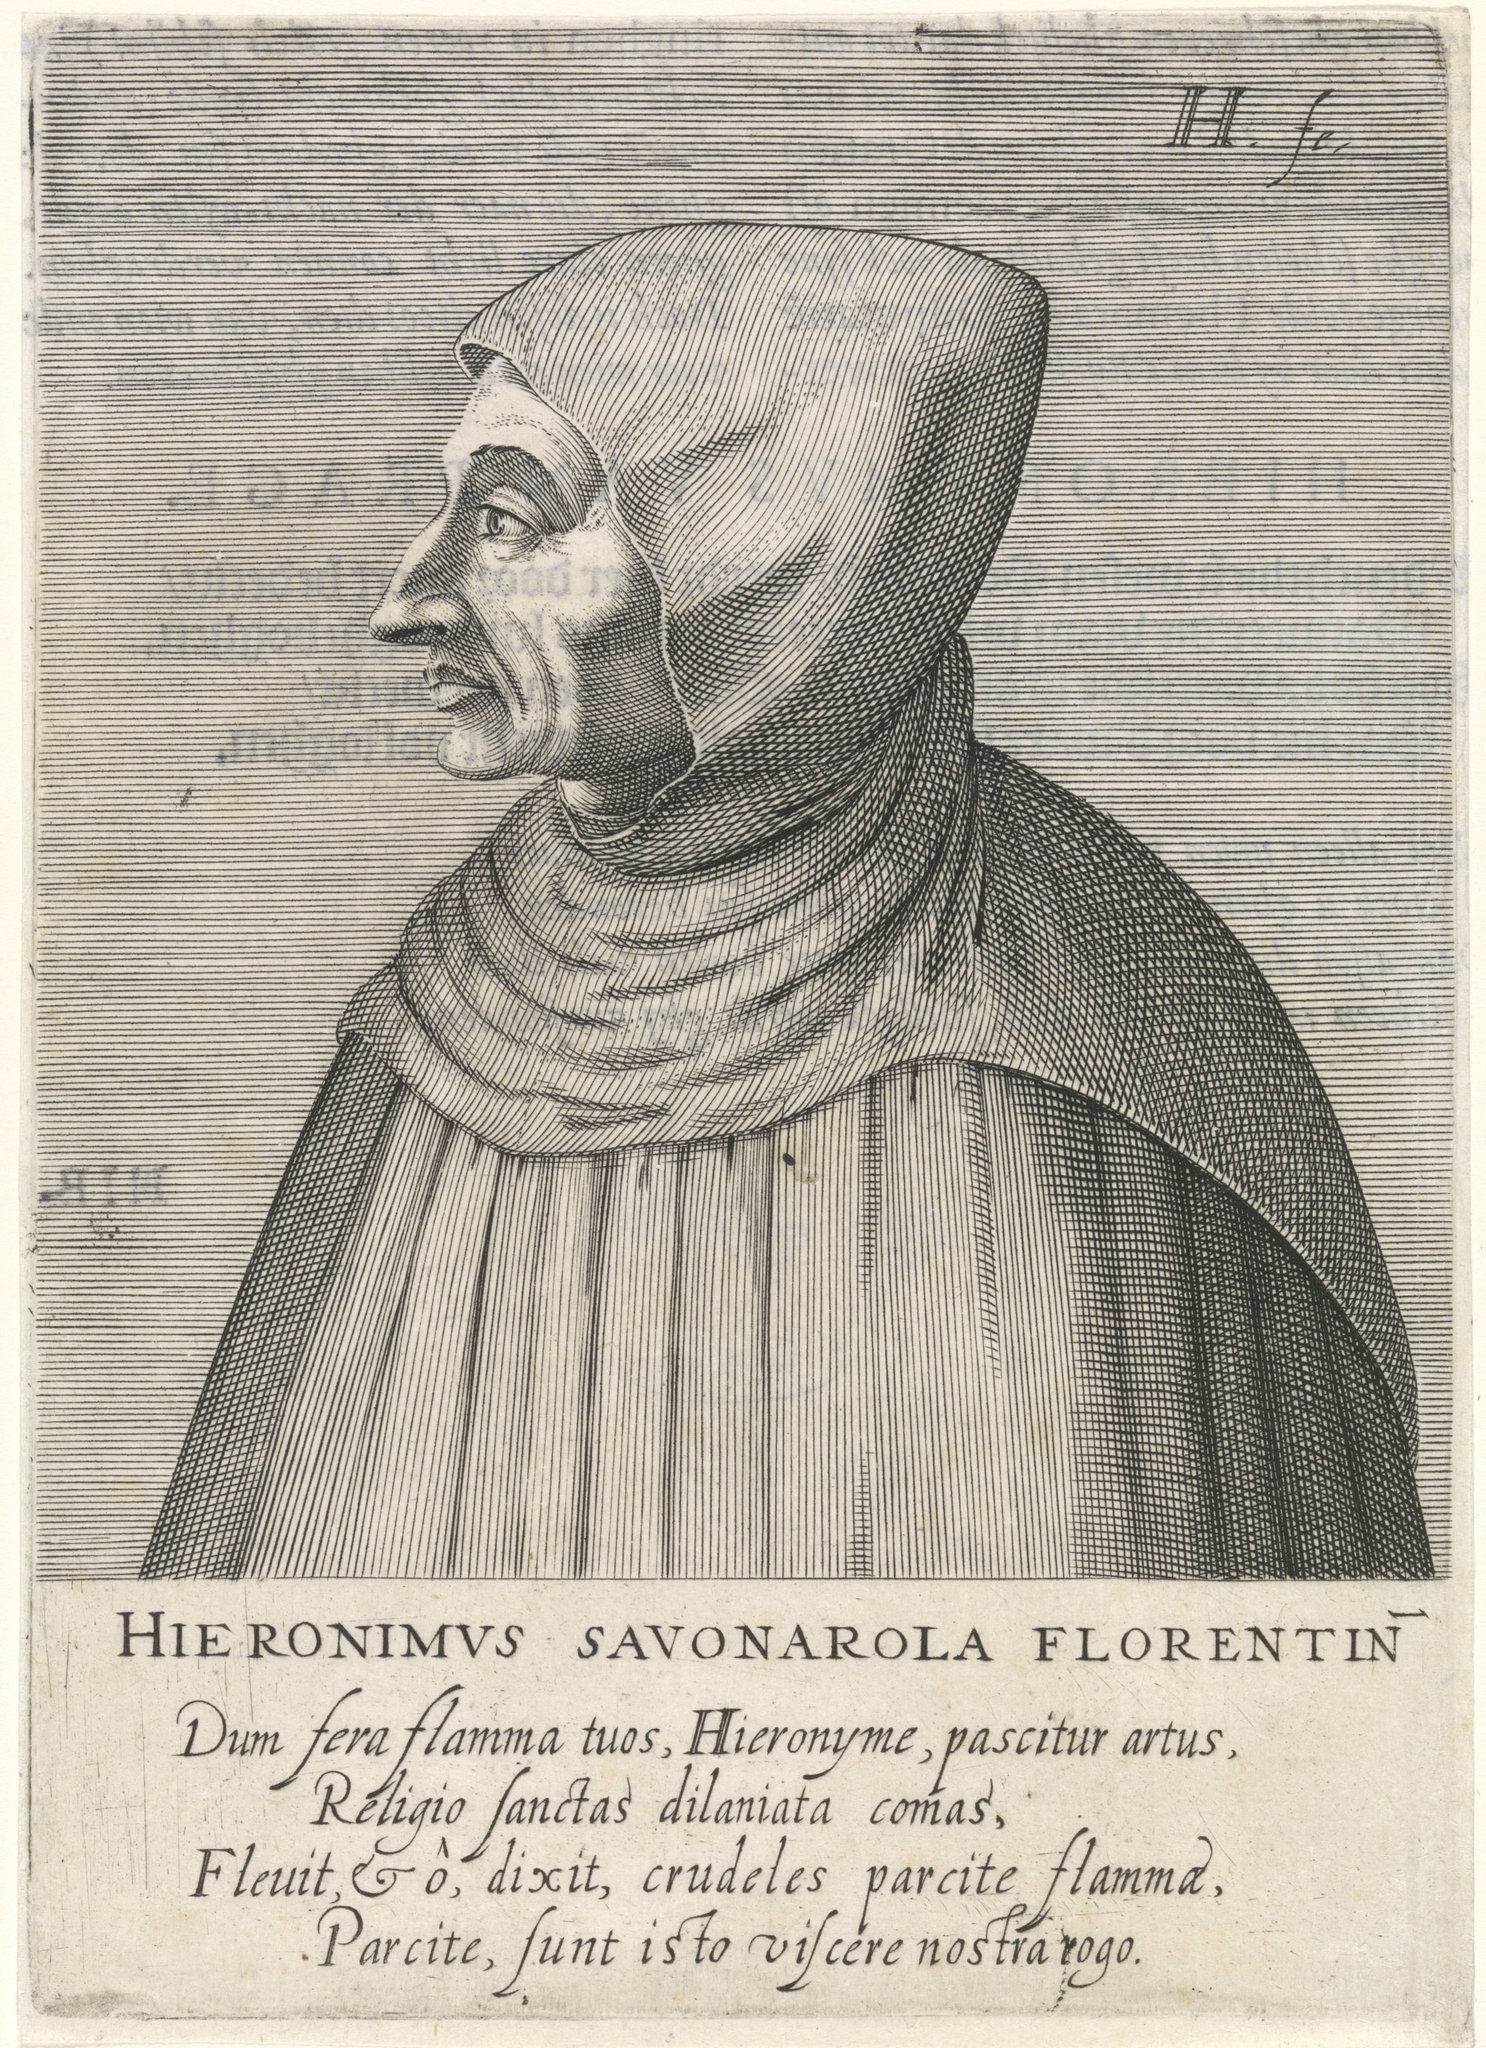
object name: print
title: Icones virorum nostra patrumq. memoria illustrium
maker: hendrick hondius (i)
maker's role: draughtsman, print maker, publisher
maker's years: 1573-1650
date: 1599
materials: paper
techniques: engraving, letterpress printing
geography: the hague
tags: priest, politician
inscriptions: collector's mark: Lugt 2228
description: Prent ook gebruikt als boekillustratie in: Jacob Verheiden, Præstantium aliquot theologorum, qui rom. antichristum præcipuè oppugnarunt, effigies. Den Haag: Hendrick Hondius I en Den Haag: B.C. Nieulandt, 1602-1603. Tevens: Arnhem, J.Janssen, 1604.